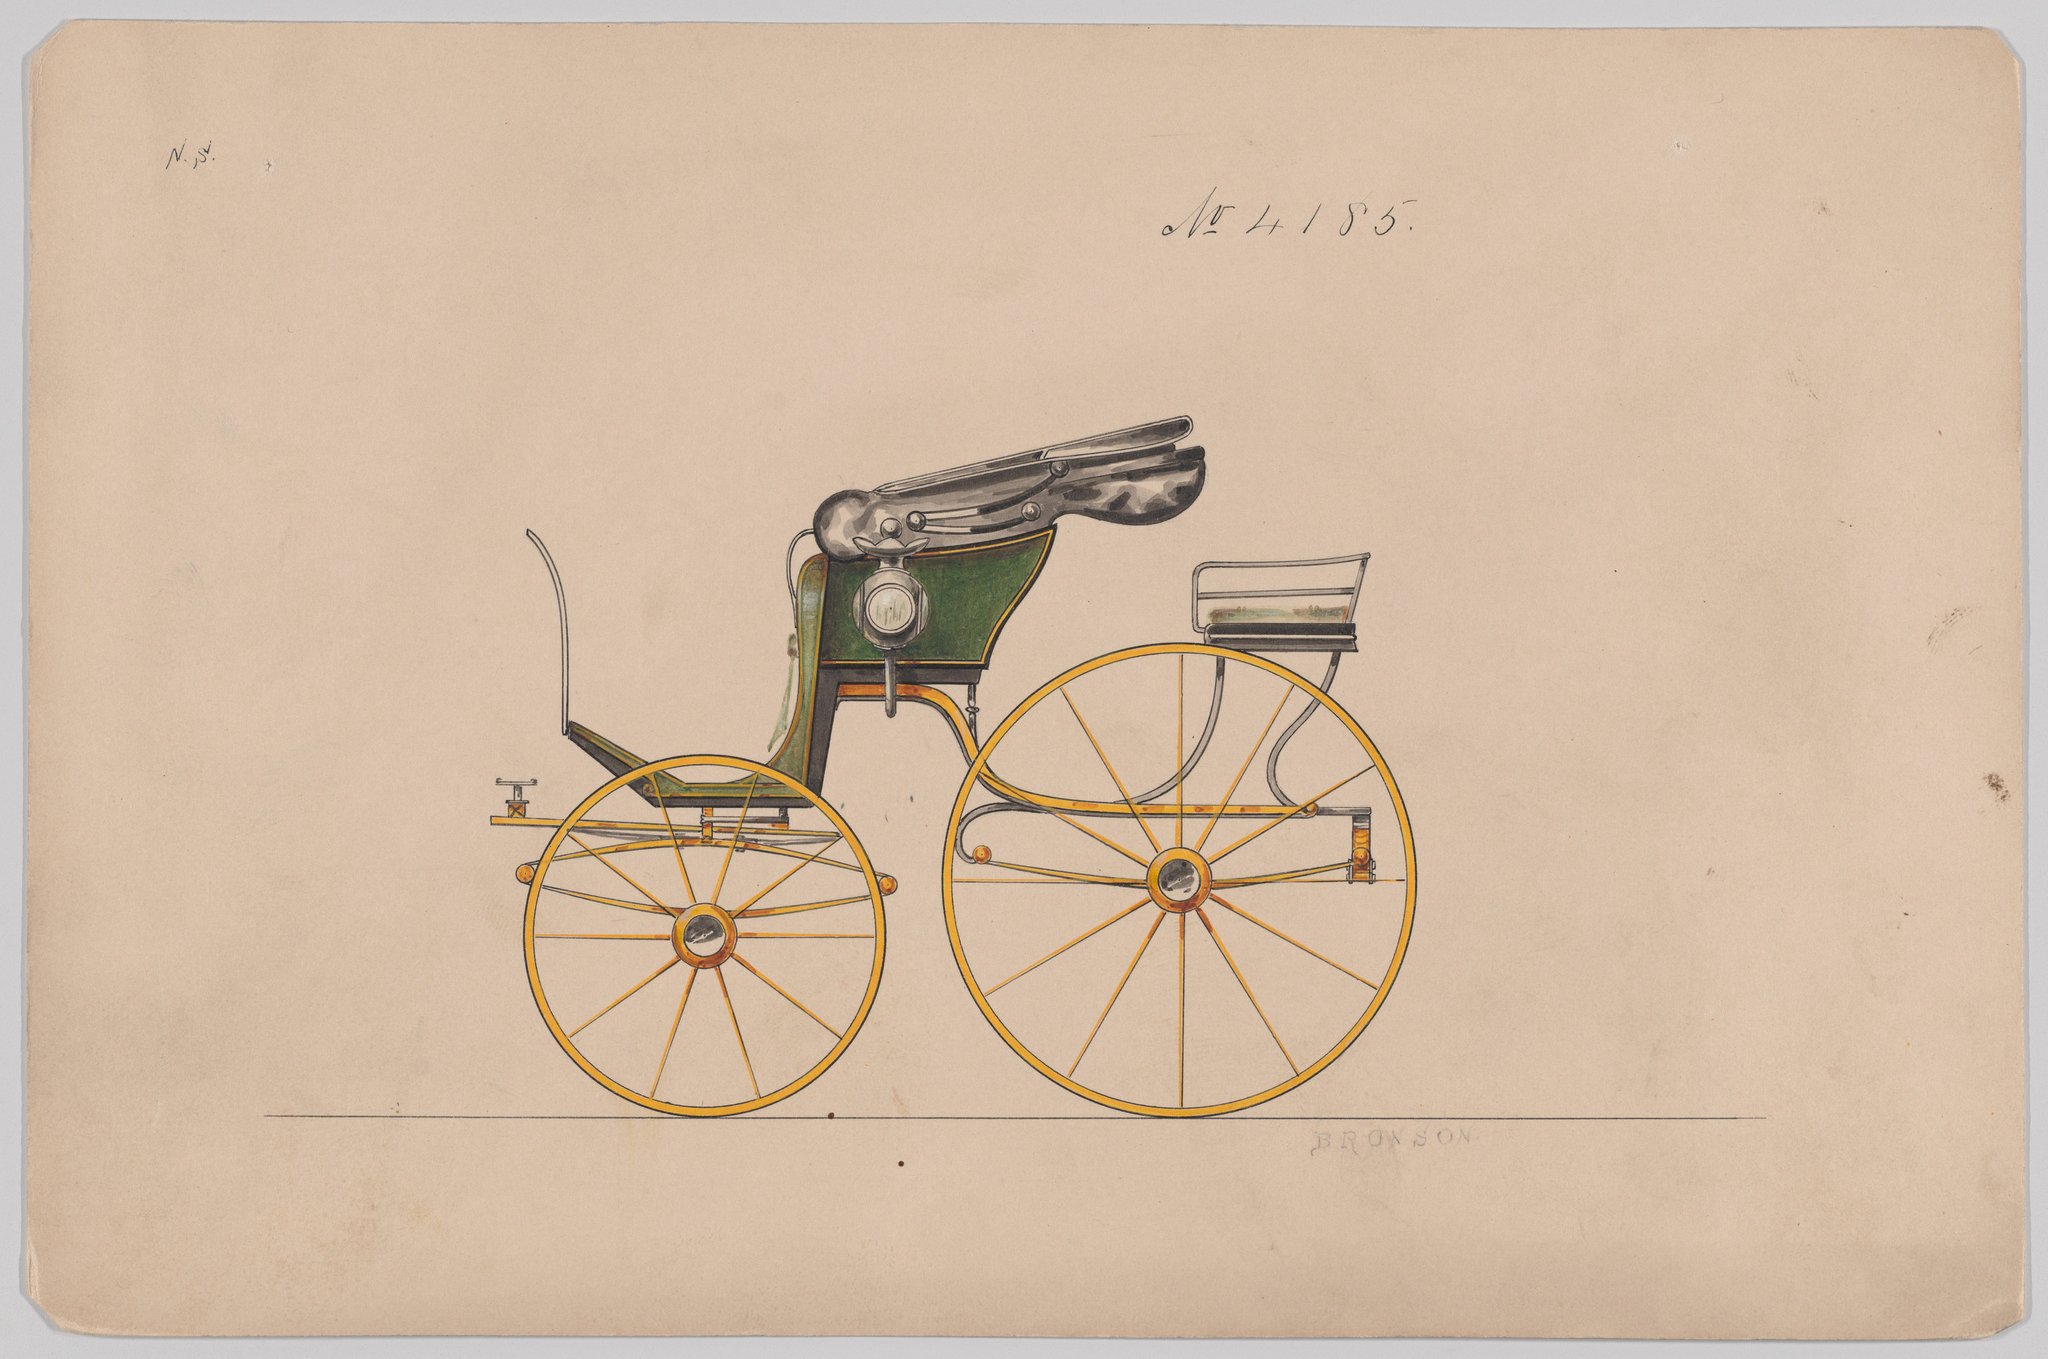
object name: drawing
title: Design for Pony Phaeton, no. 4185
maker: brewster & co.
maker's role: manufacturer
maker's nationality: american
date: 1892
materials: gouache, ink, watercolor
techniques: pen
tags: carriages